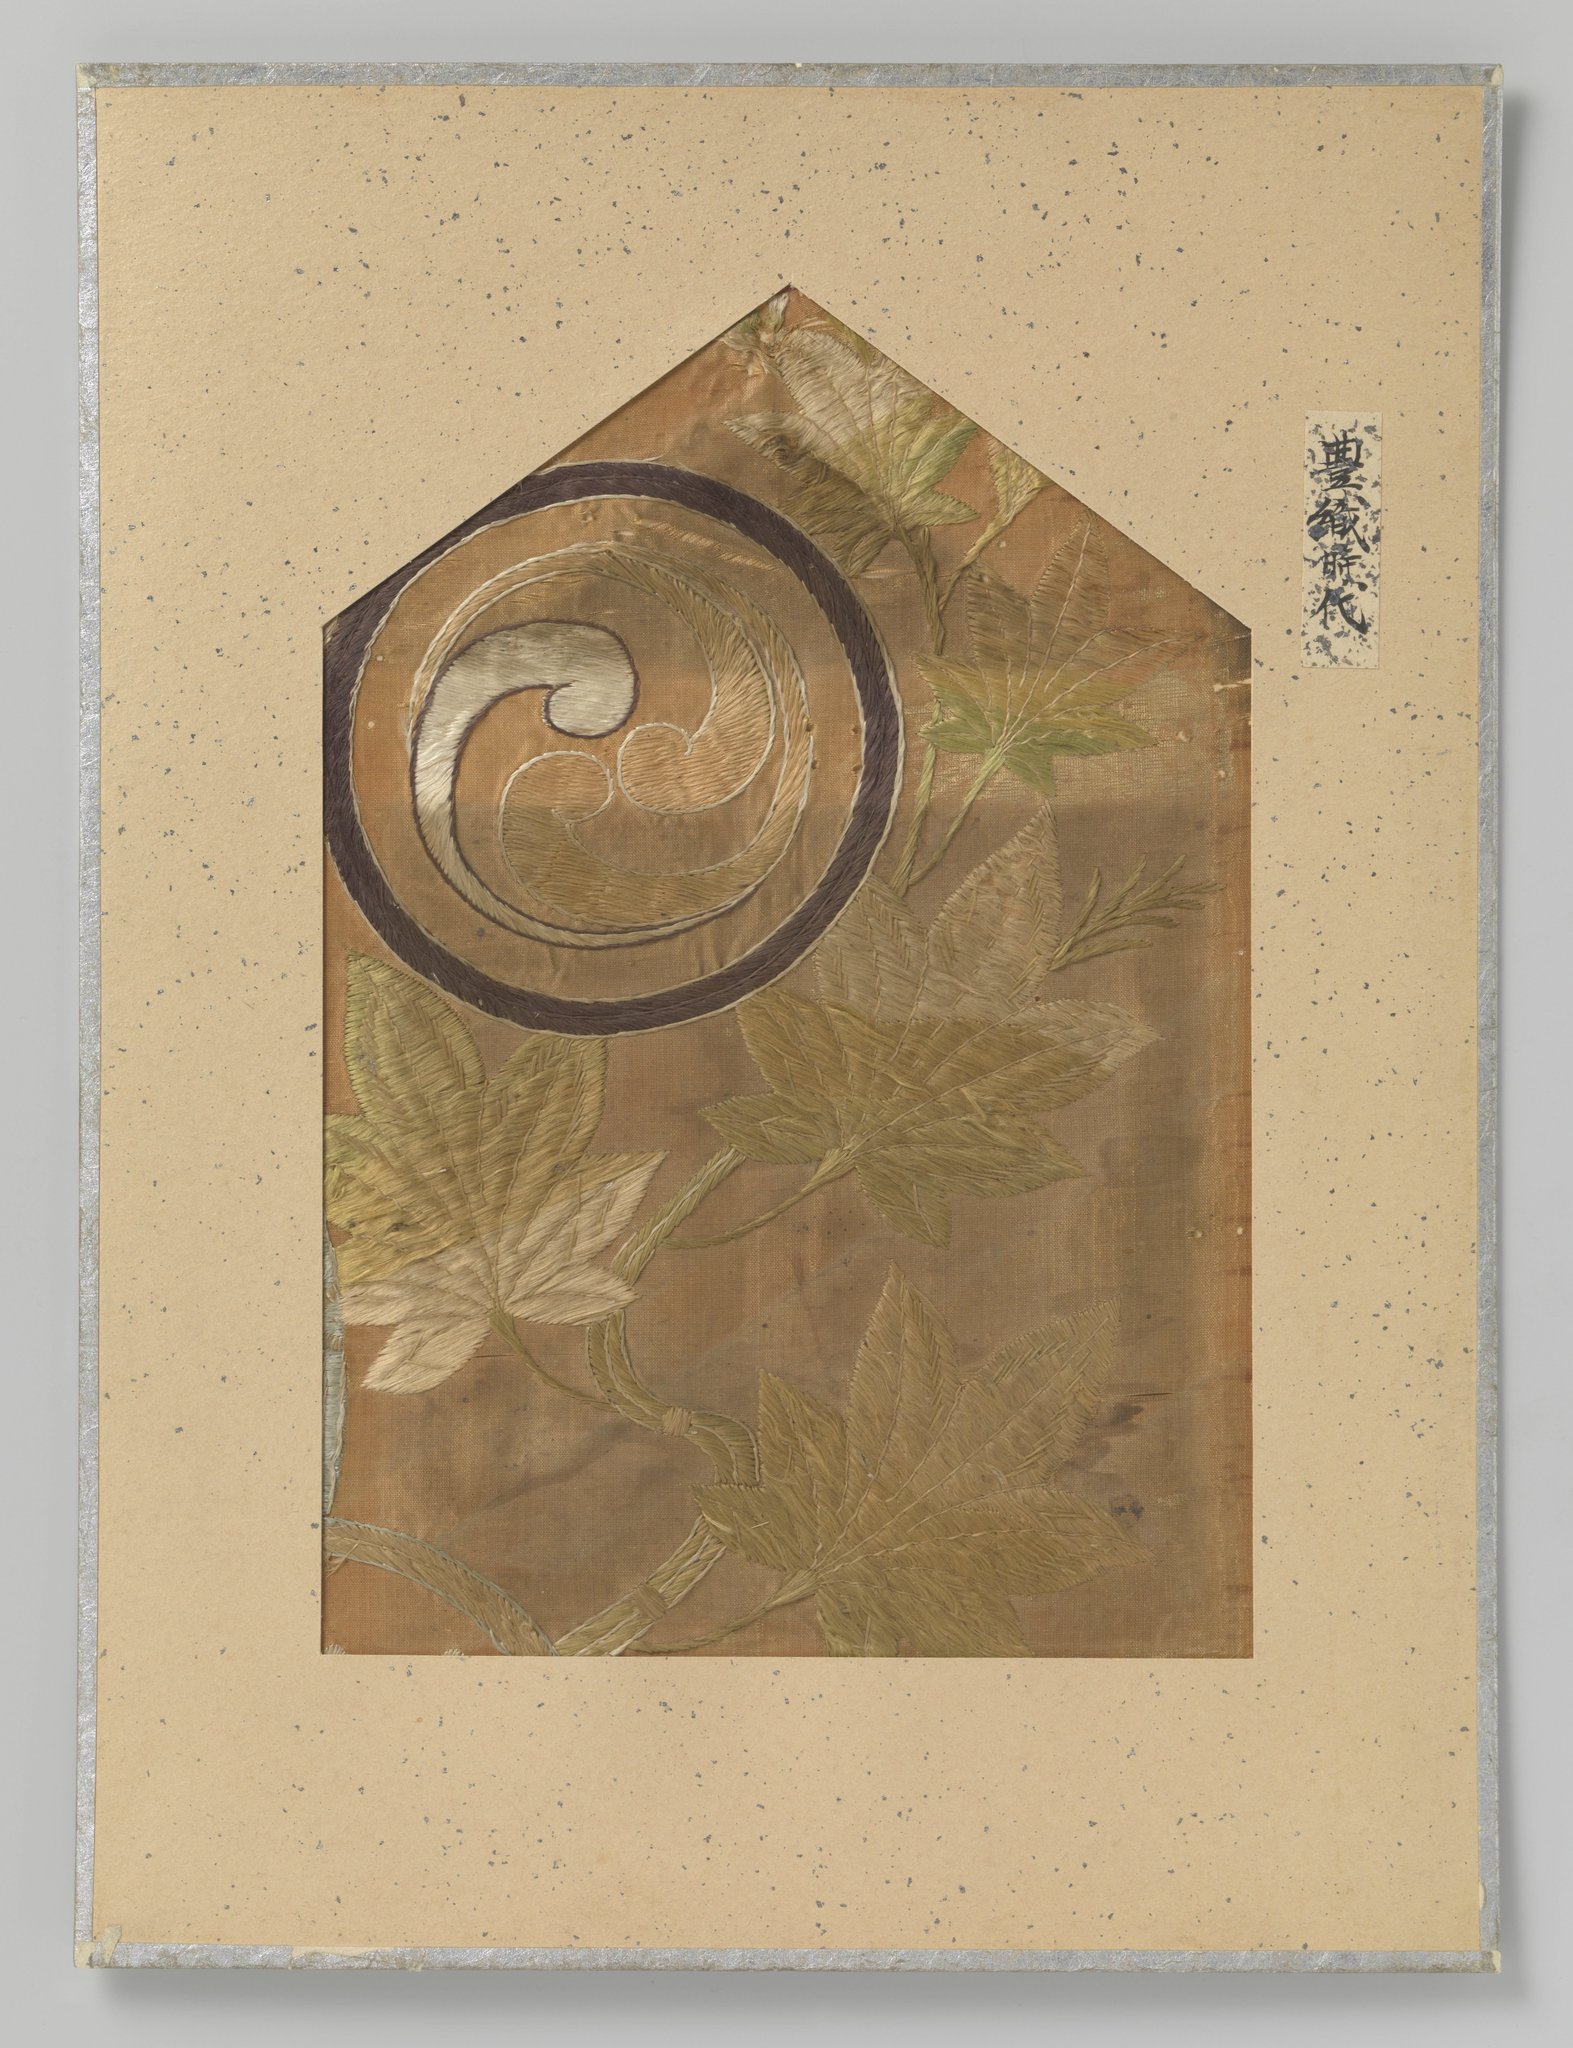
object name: textile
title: Fragment textiel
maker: Anonymous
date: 1575-1600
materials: silk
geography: japan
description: Textielfragment, borduursel voorstellende bloemen, bladeren en de Mitsu-domo-e.